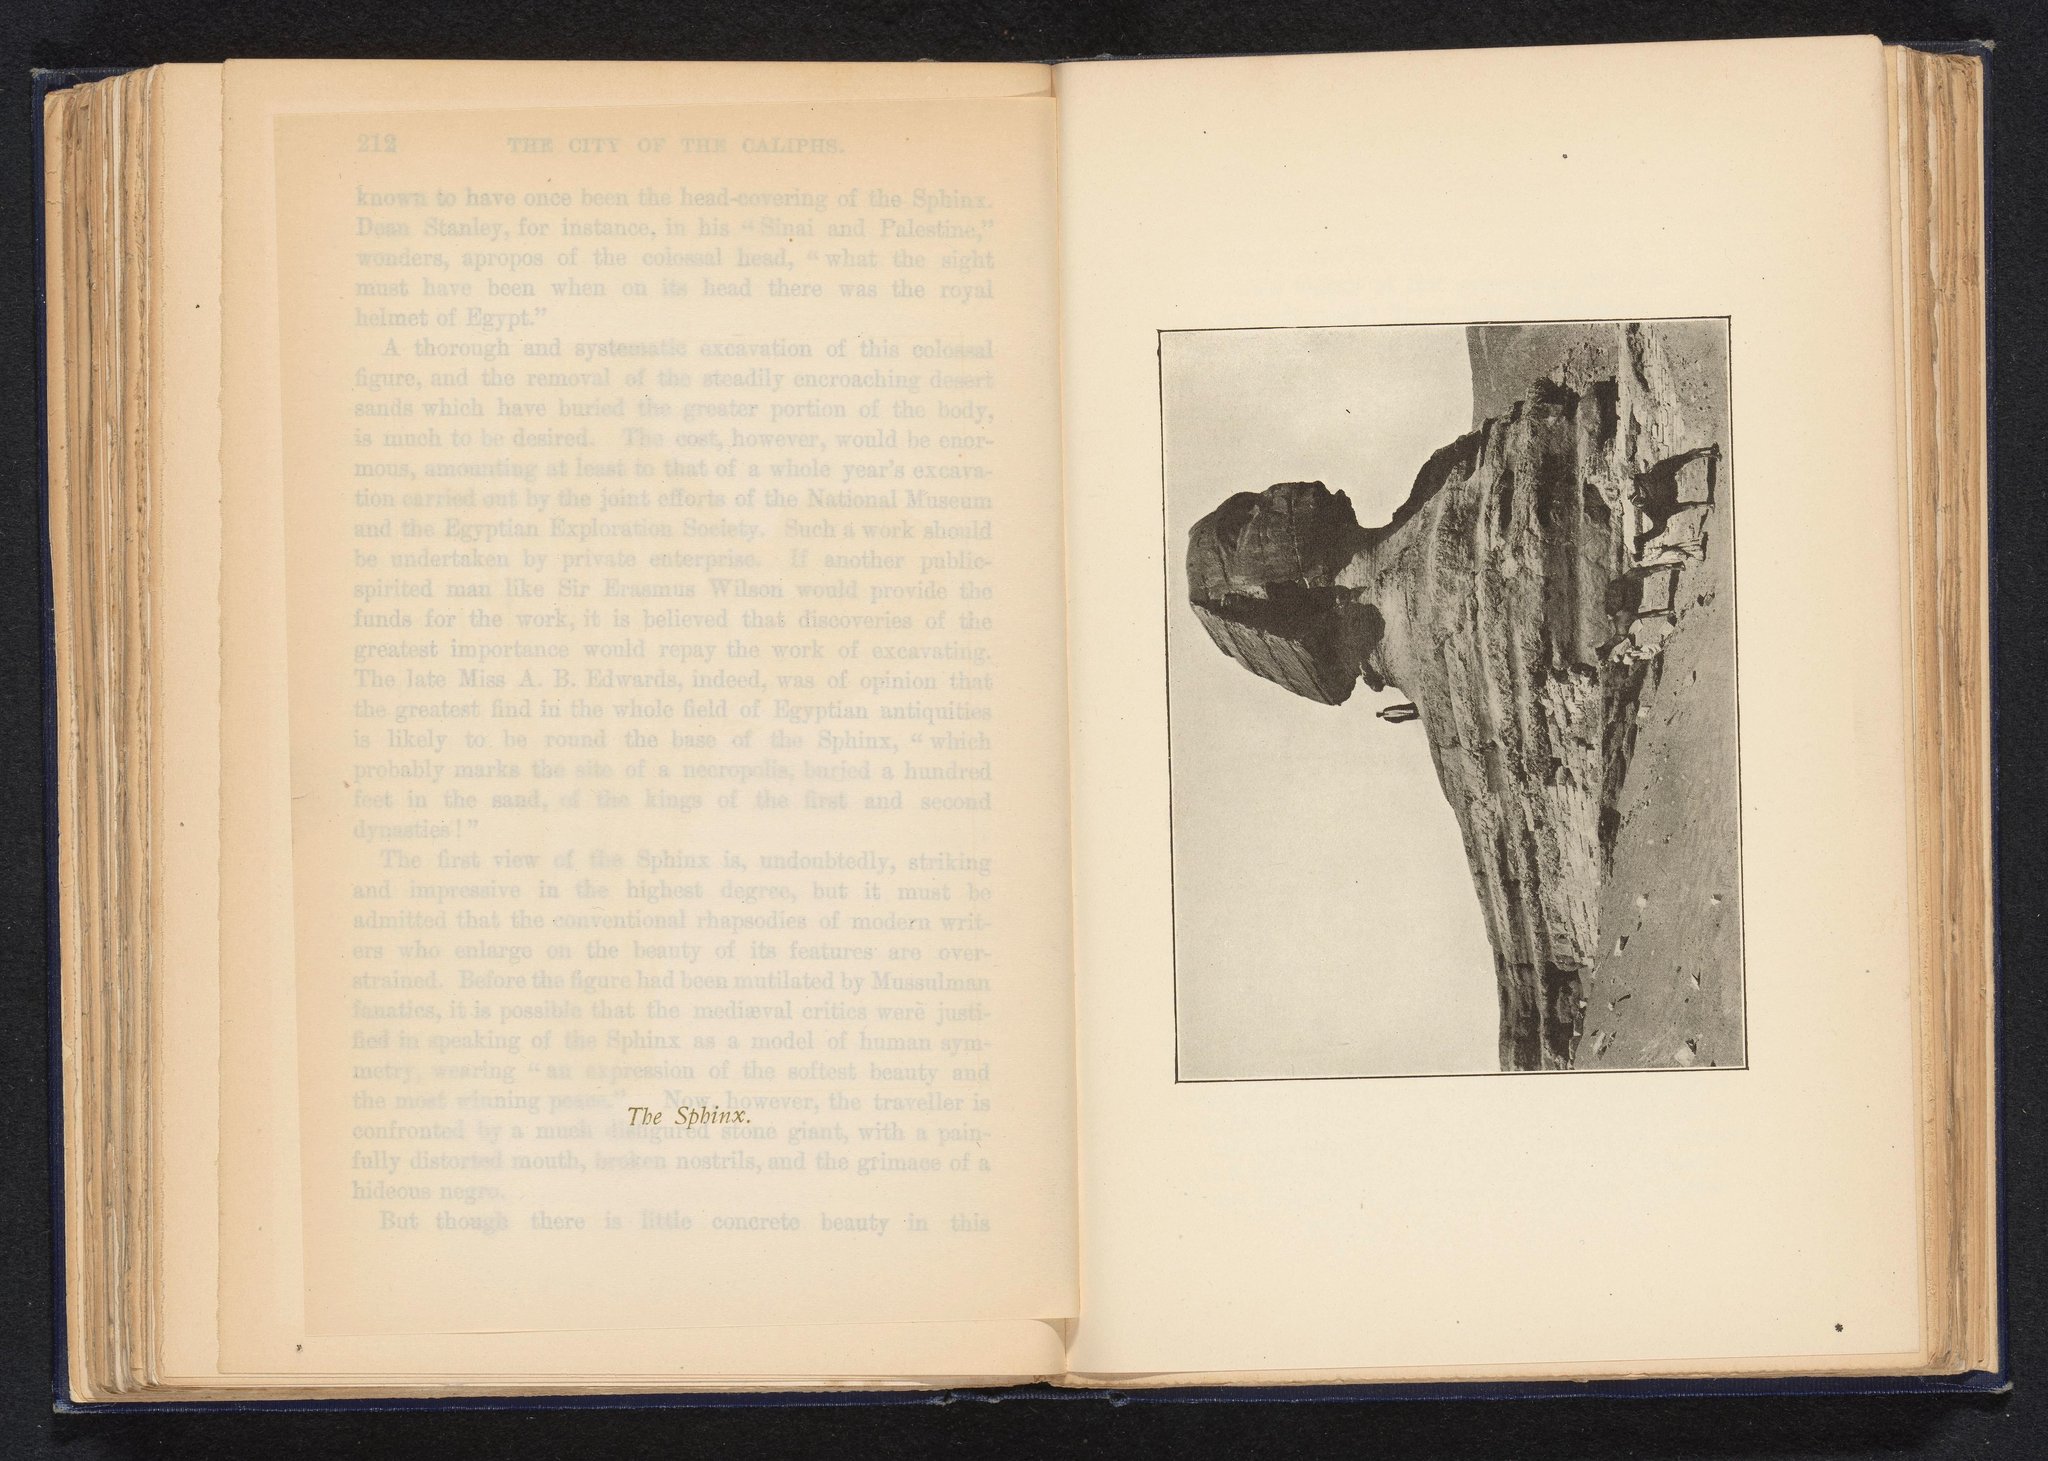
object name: page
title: The Sphinx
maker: Anonymous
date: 1891-1901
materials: paper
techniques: autotype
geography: gizeh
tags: sphinx (lion/woman); 'sfinge' (ripa)